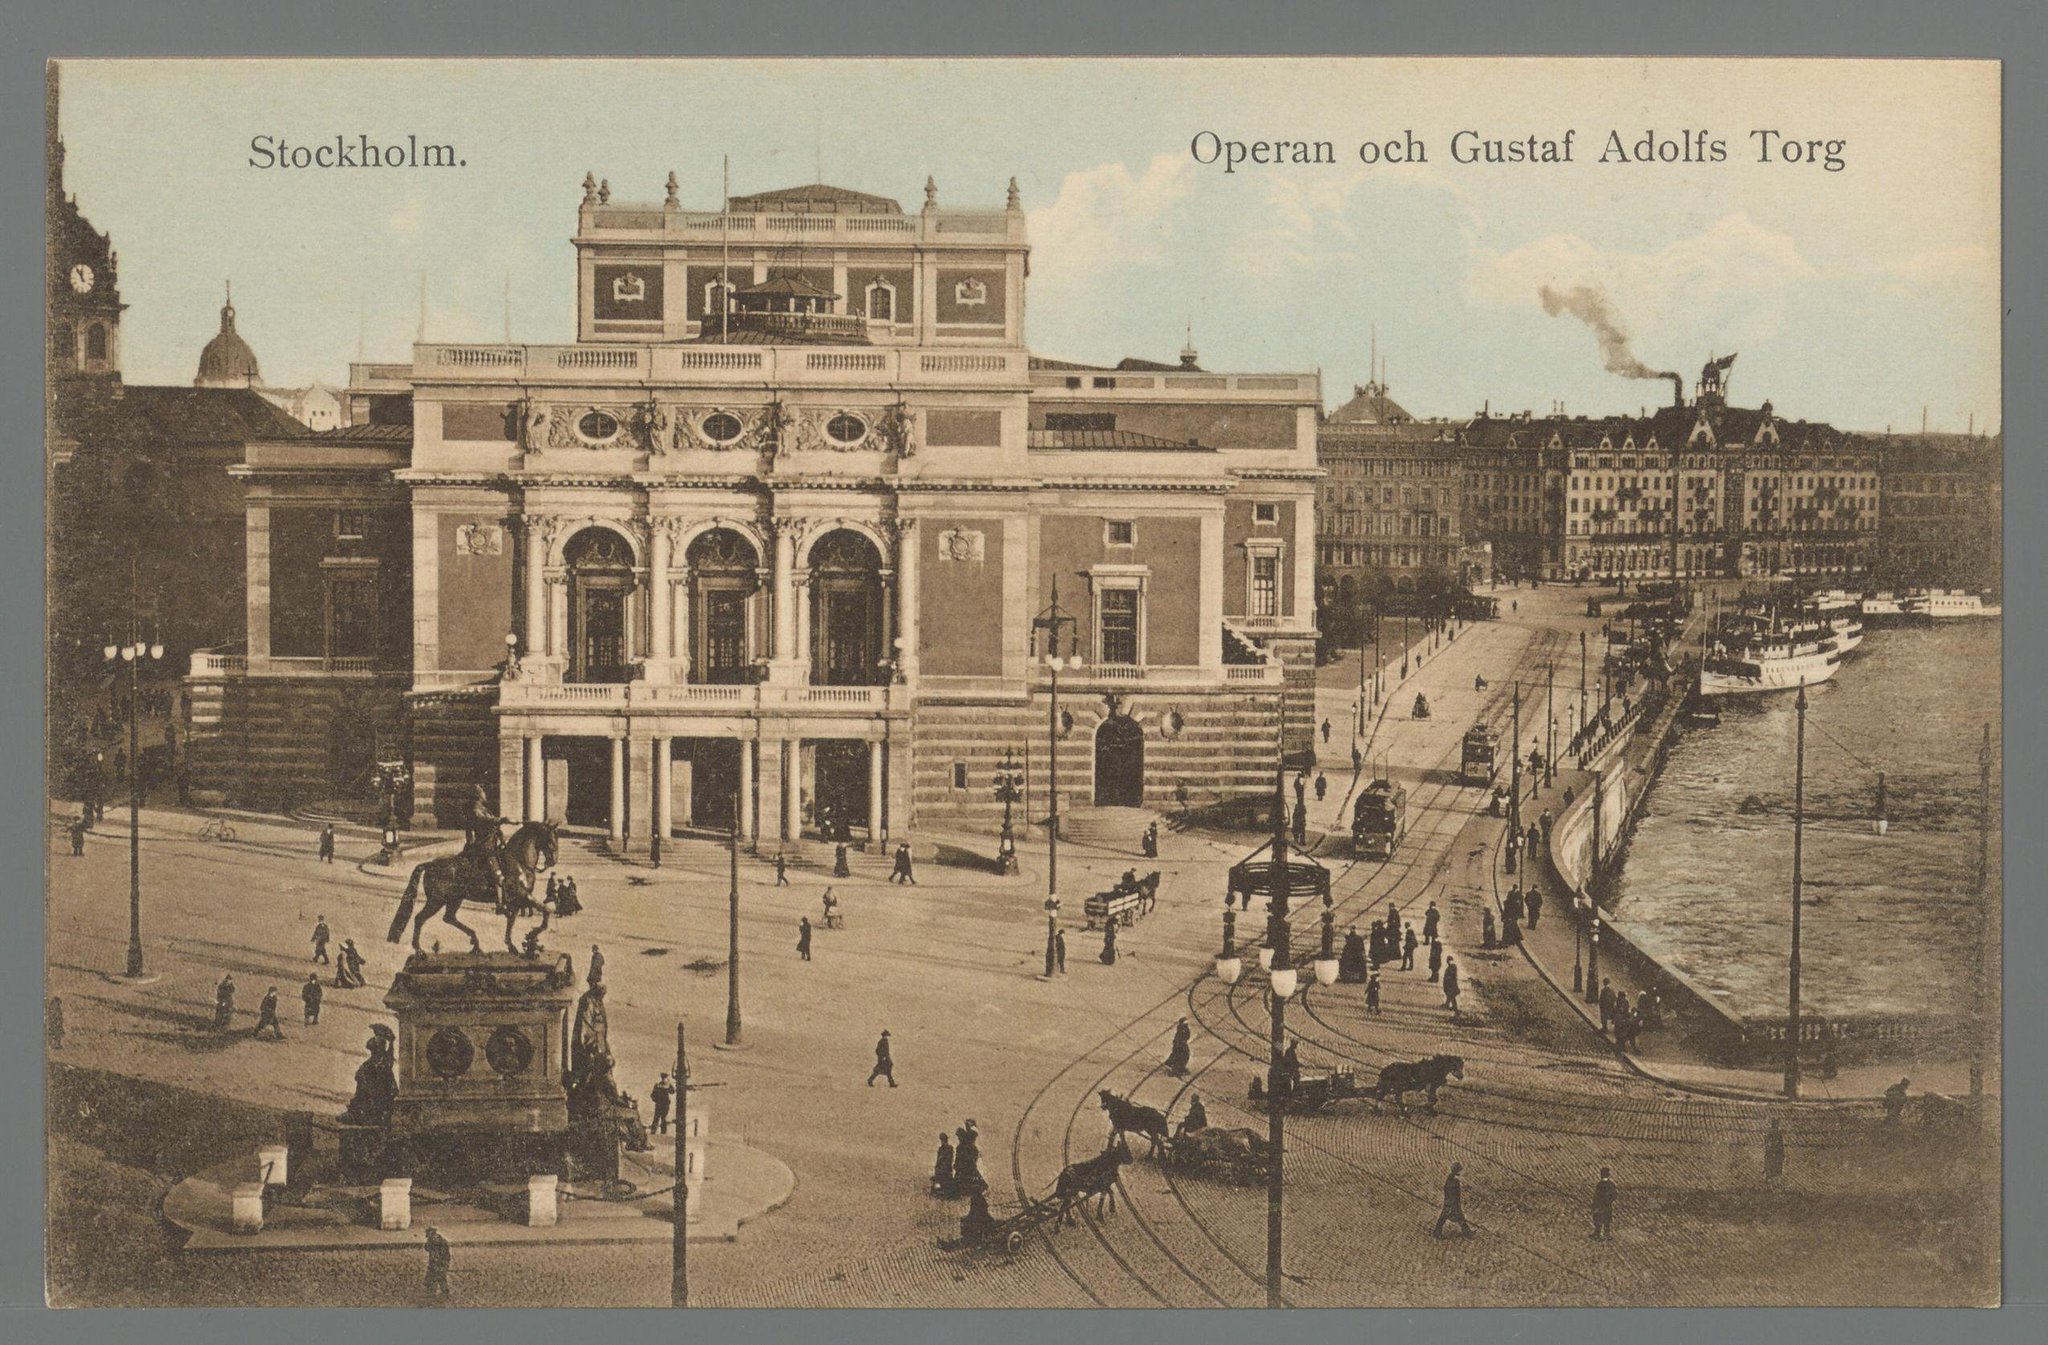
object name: photomechanical print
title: Stockholm. Operan och Gustaf Adolfs Torg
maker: Anonymous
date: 1905-1930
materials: cardboard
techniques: photograph, lithograph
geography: stockholm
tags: monument, statue, opera house